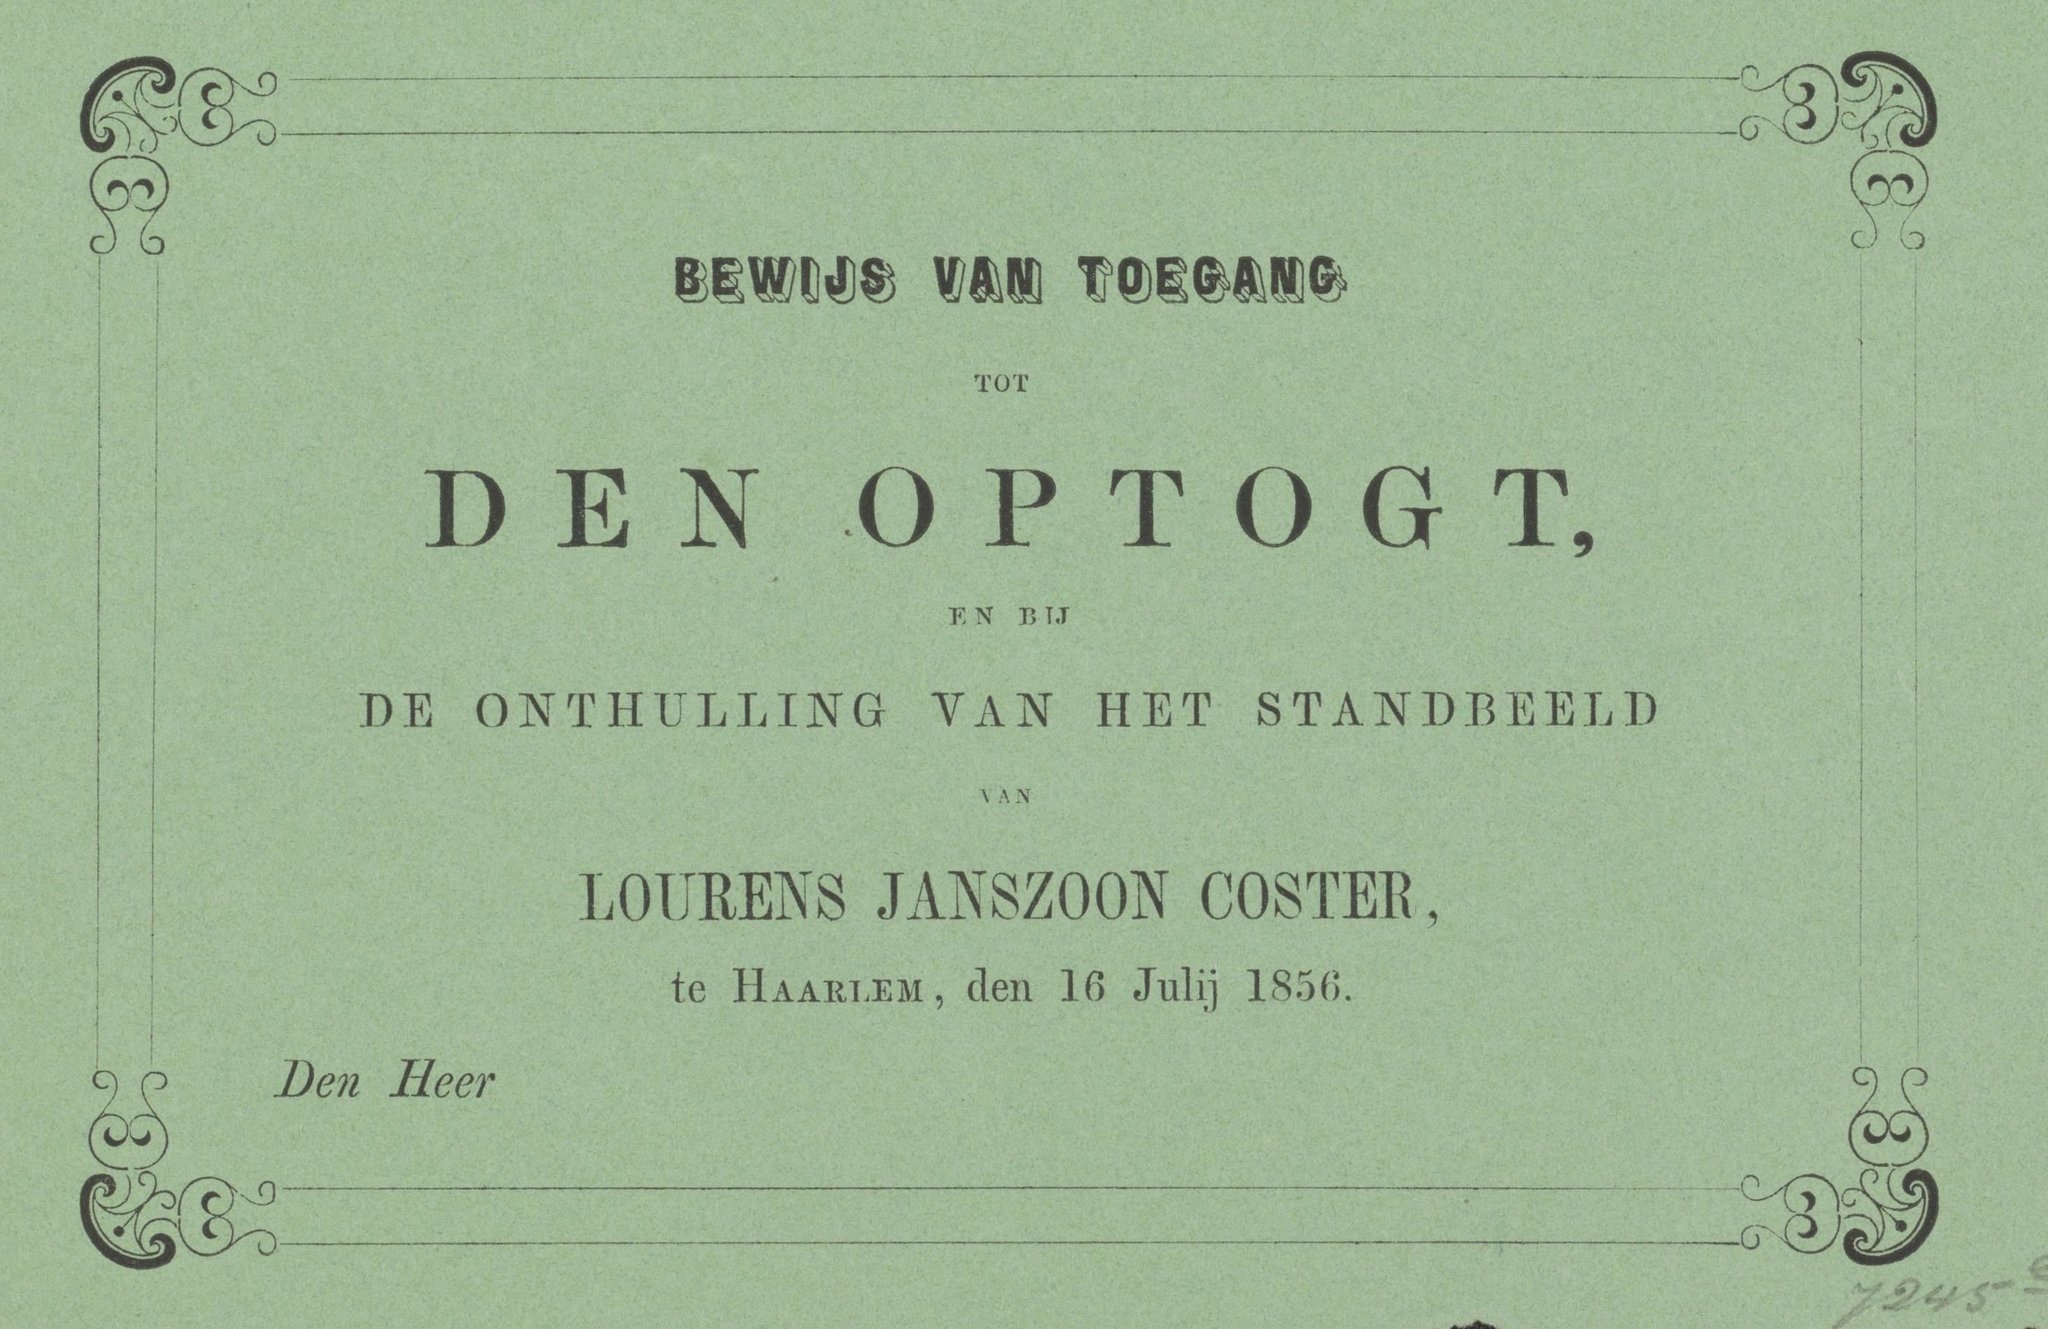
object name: admission ticket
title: Bewijs van Toegang tot Den Optogt, en bij de onthulling van het standbeeld van Lourens Janszoon Coster, te Haarlem, den 16 Julij 1856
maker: Anonymous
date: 1856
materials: paper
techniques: letterpress printing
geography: haarlem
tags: haarlem, monument, statue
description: Toegangsbewijs voor de optocht en voor ceremonie van de onthulling van het standbeeld van Laurens Coster op de Grote Markt te Haarlem, 16 juli 1856. De naam niet ingevuld.